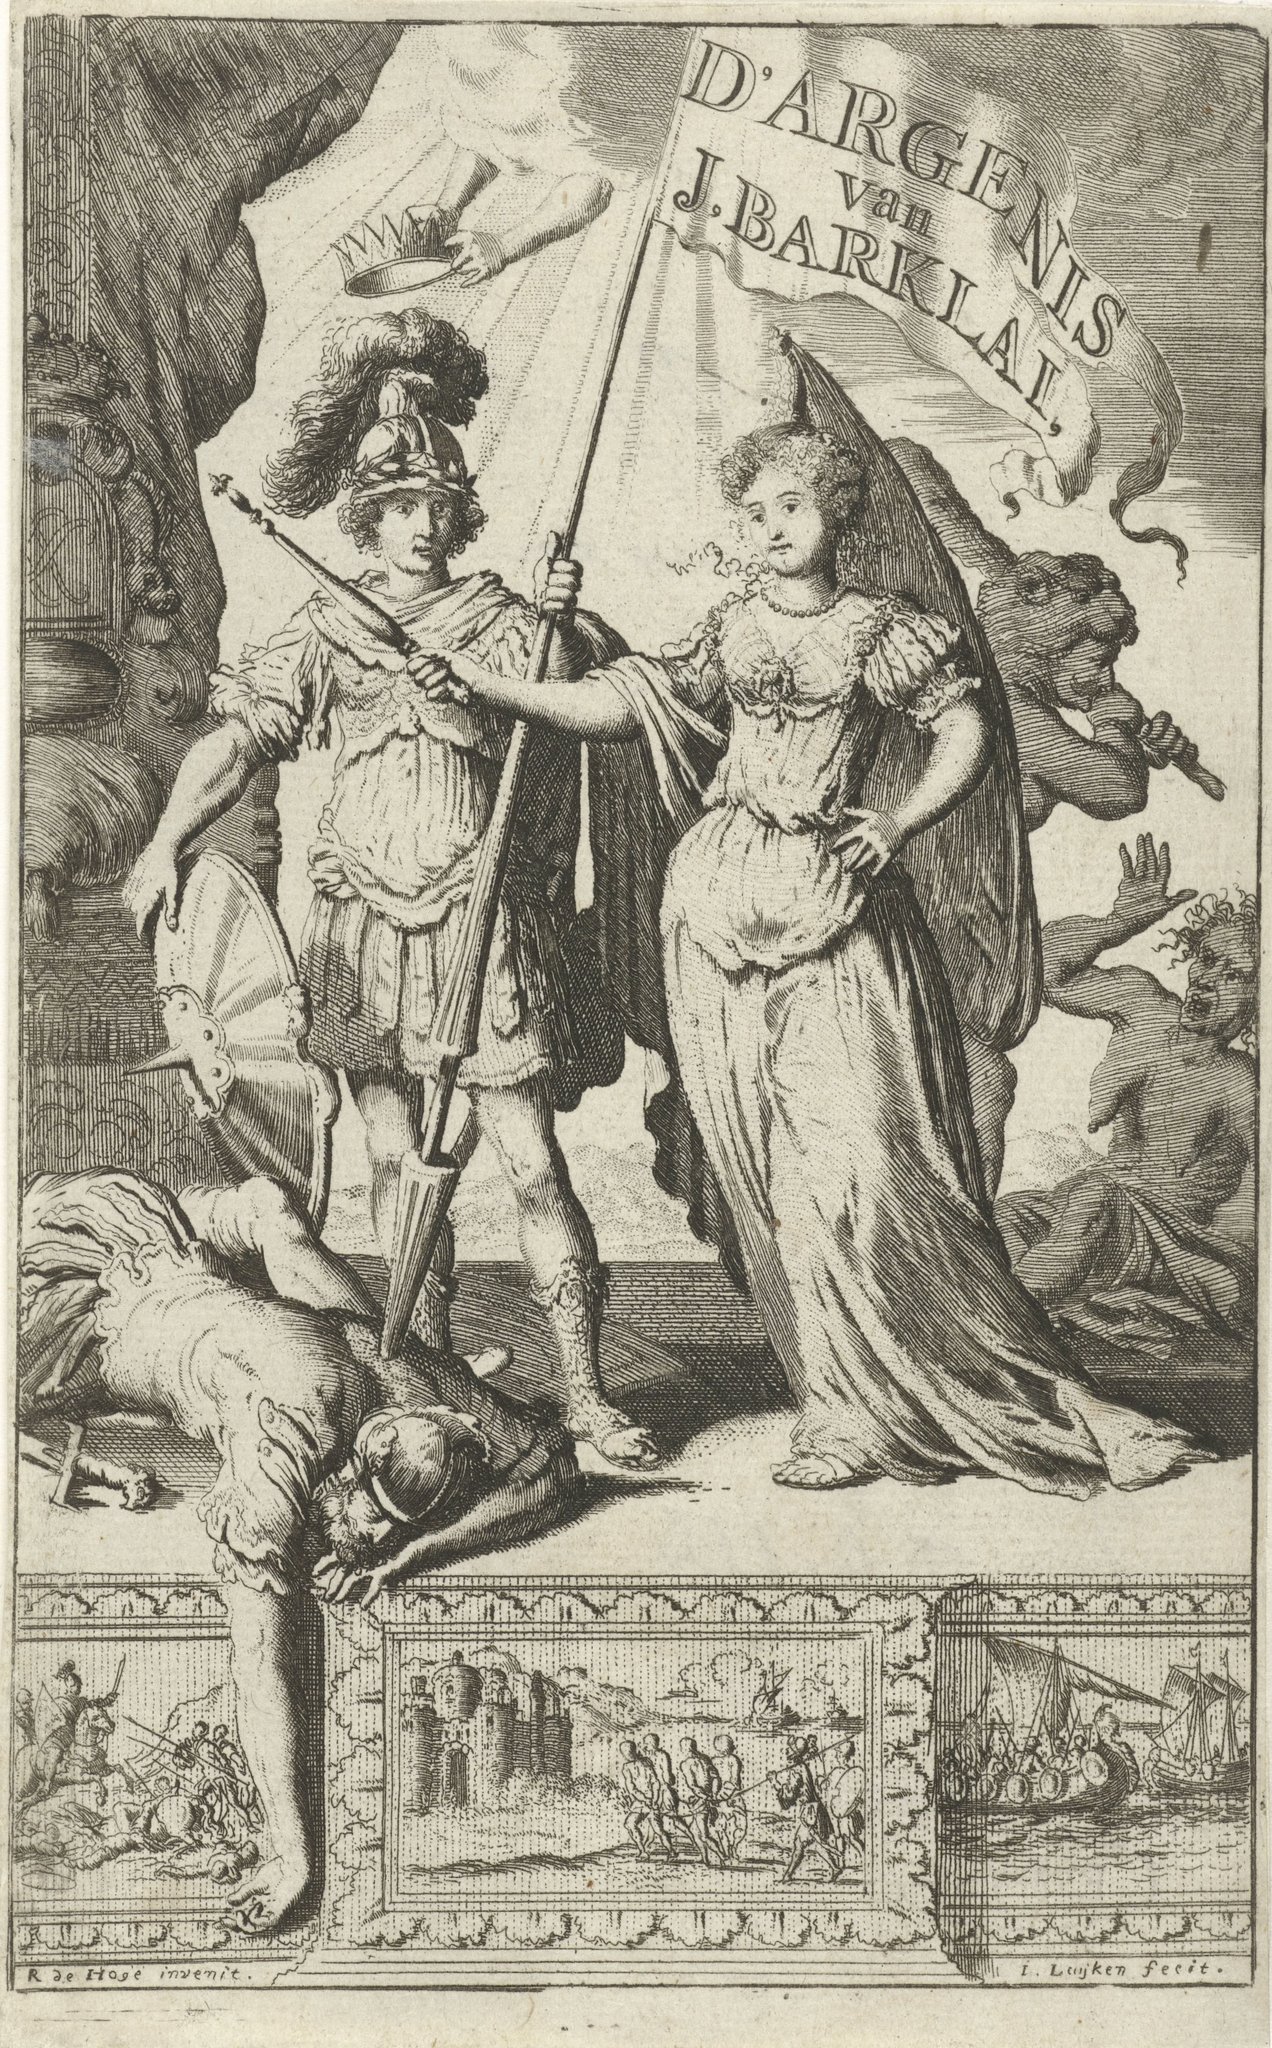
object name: print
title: Vorstin en een Romeinse krijgsman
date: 1680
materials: paper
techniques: etching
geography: amsterdam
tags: ruler, sovereign - bb - female ruler, the soldier; the soldier's life, extinct, 'historical' peoples (with name)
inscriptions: collector's mark: Lugt 2228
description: Een vorstin staat met haar scepter naast een Romeinse krijgsman aan wiens voeten de overwonnen vijand ligt. De krijgsman wordt vanuit de wolken gekroond. Op de achtergrond verslaat de gepersonifieerde Kracht de Nijd.